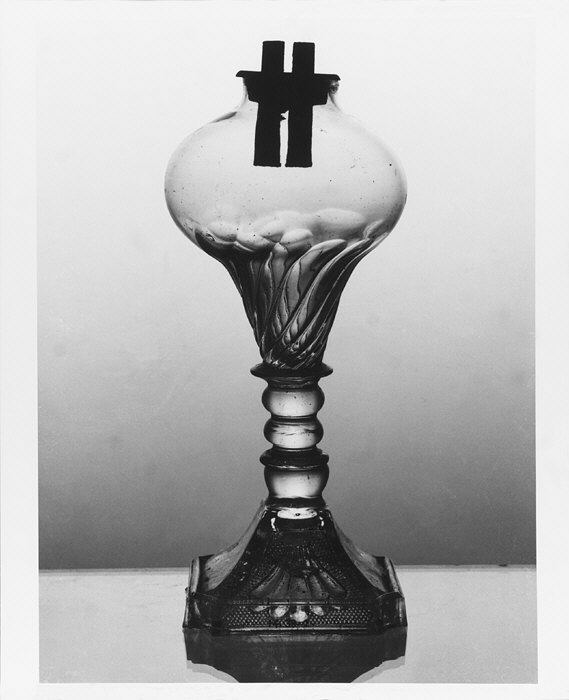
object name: whale oil lamp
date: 1825-1850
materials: glass